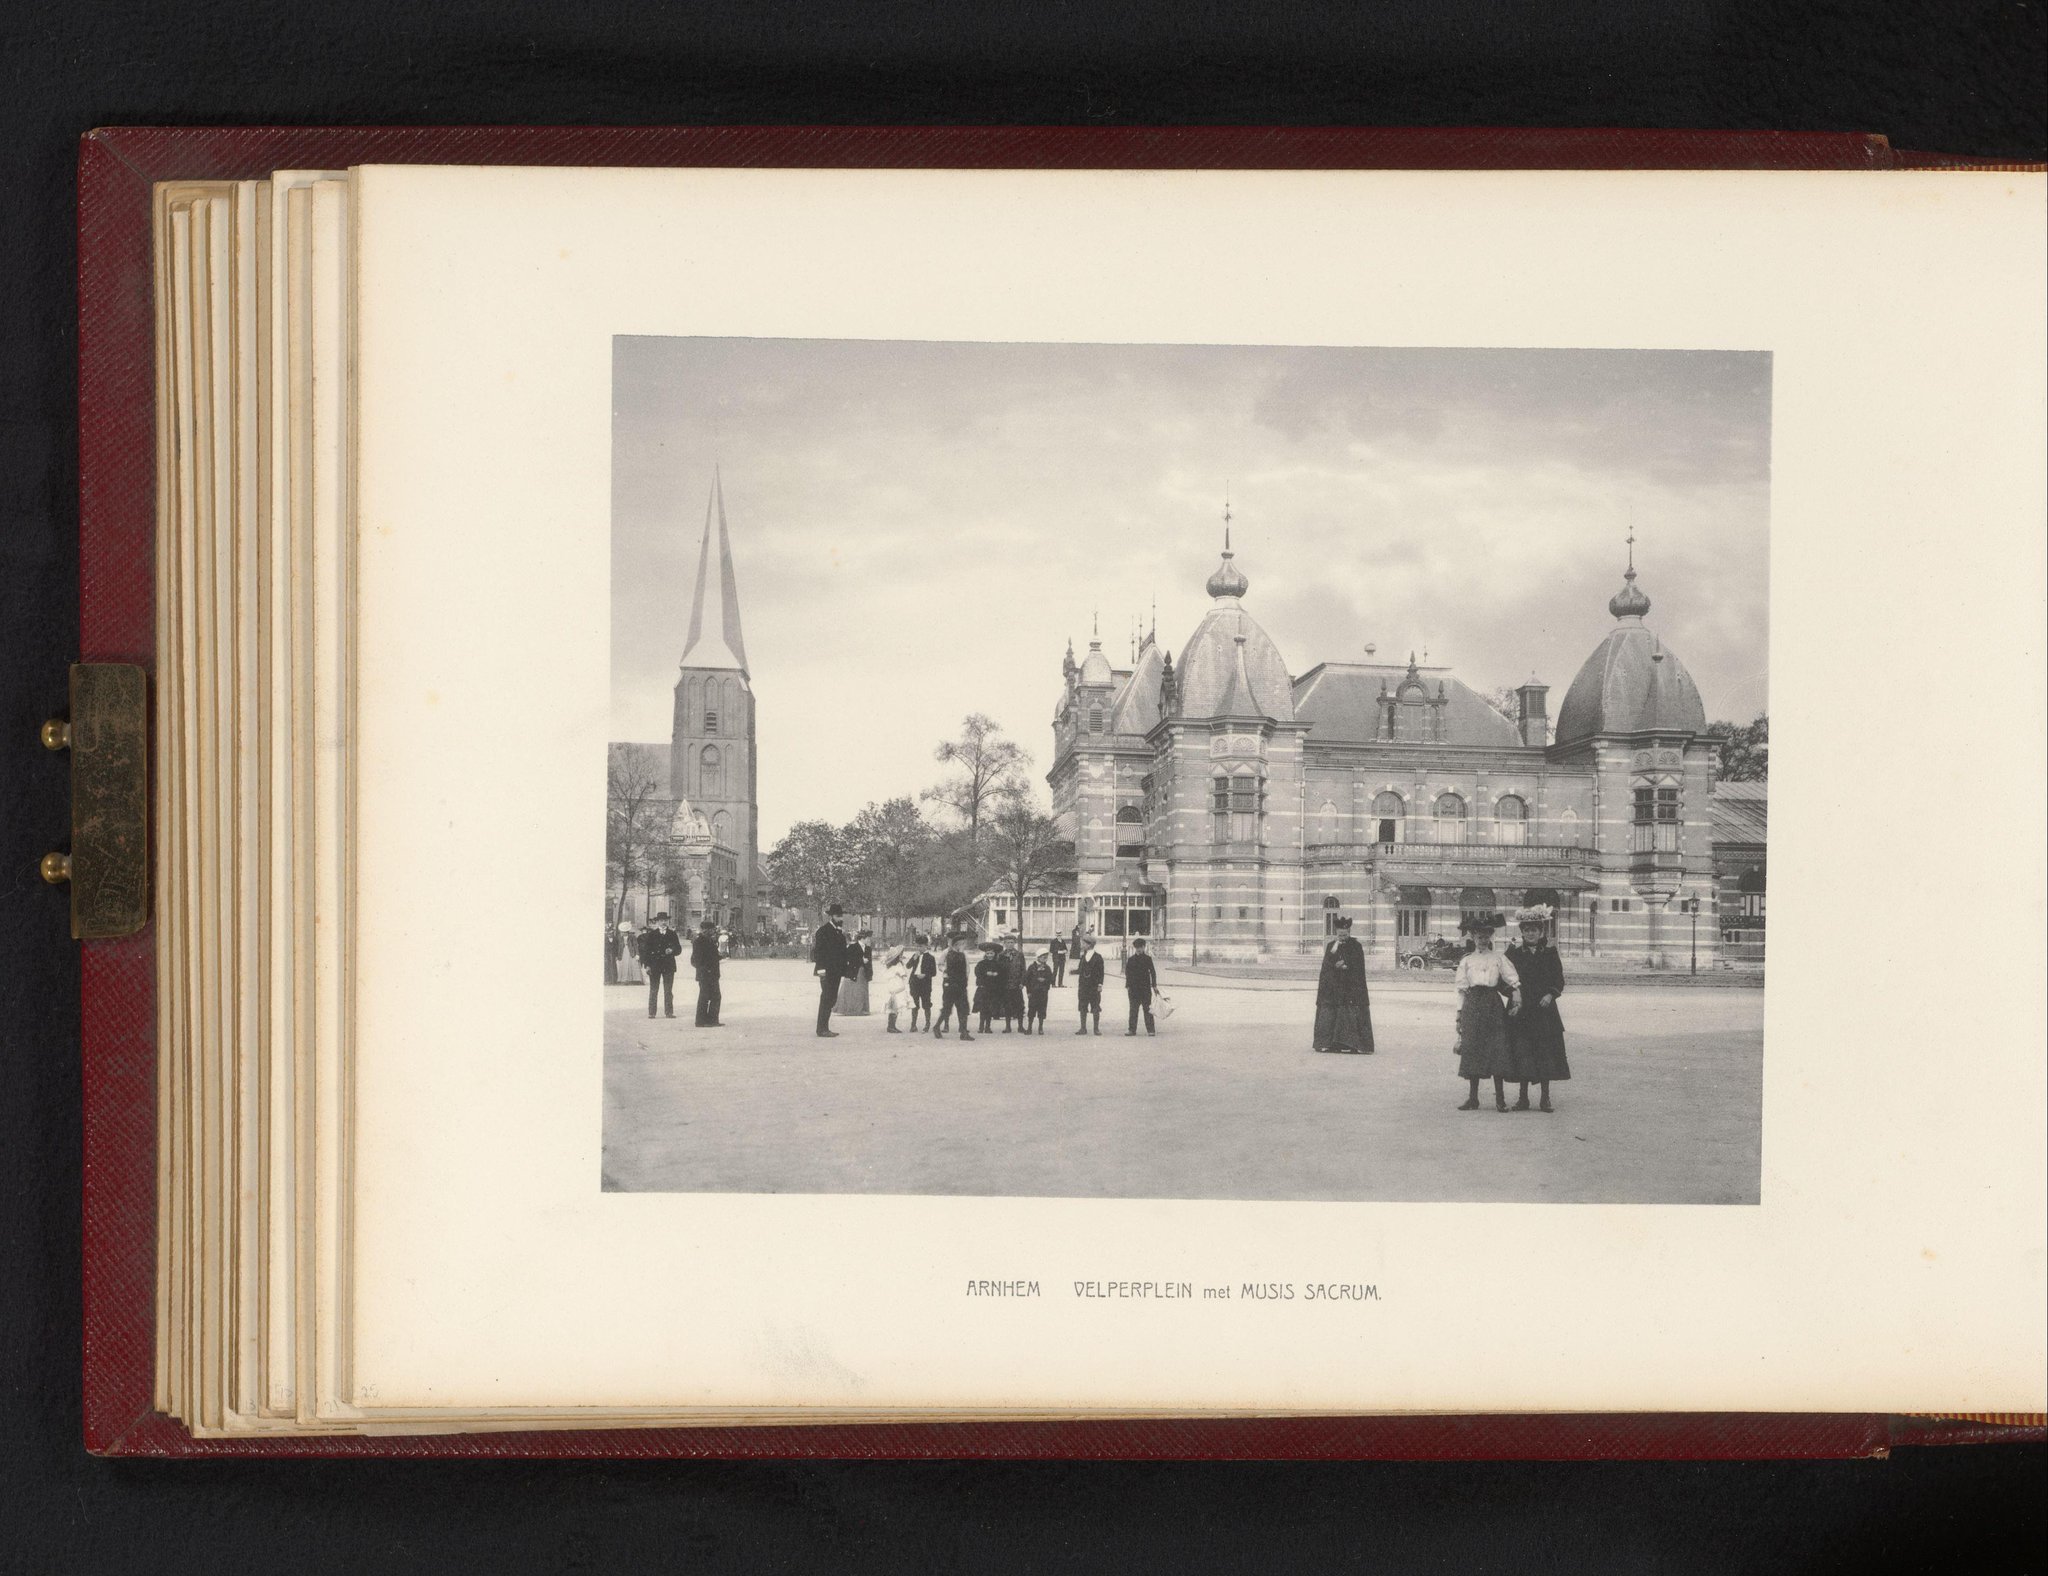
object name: album leaf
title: Arnhem Velperplein met Musis Sacrum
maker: Anonymous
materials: paper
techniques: photograph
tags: square, place, circus, etc., historical persons, concert hall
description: Deze pagina maakt deel uit van een album.